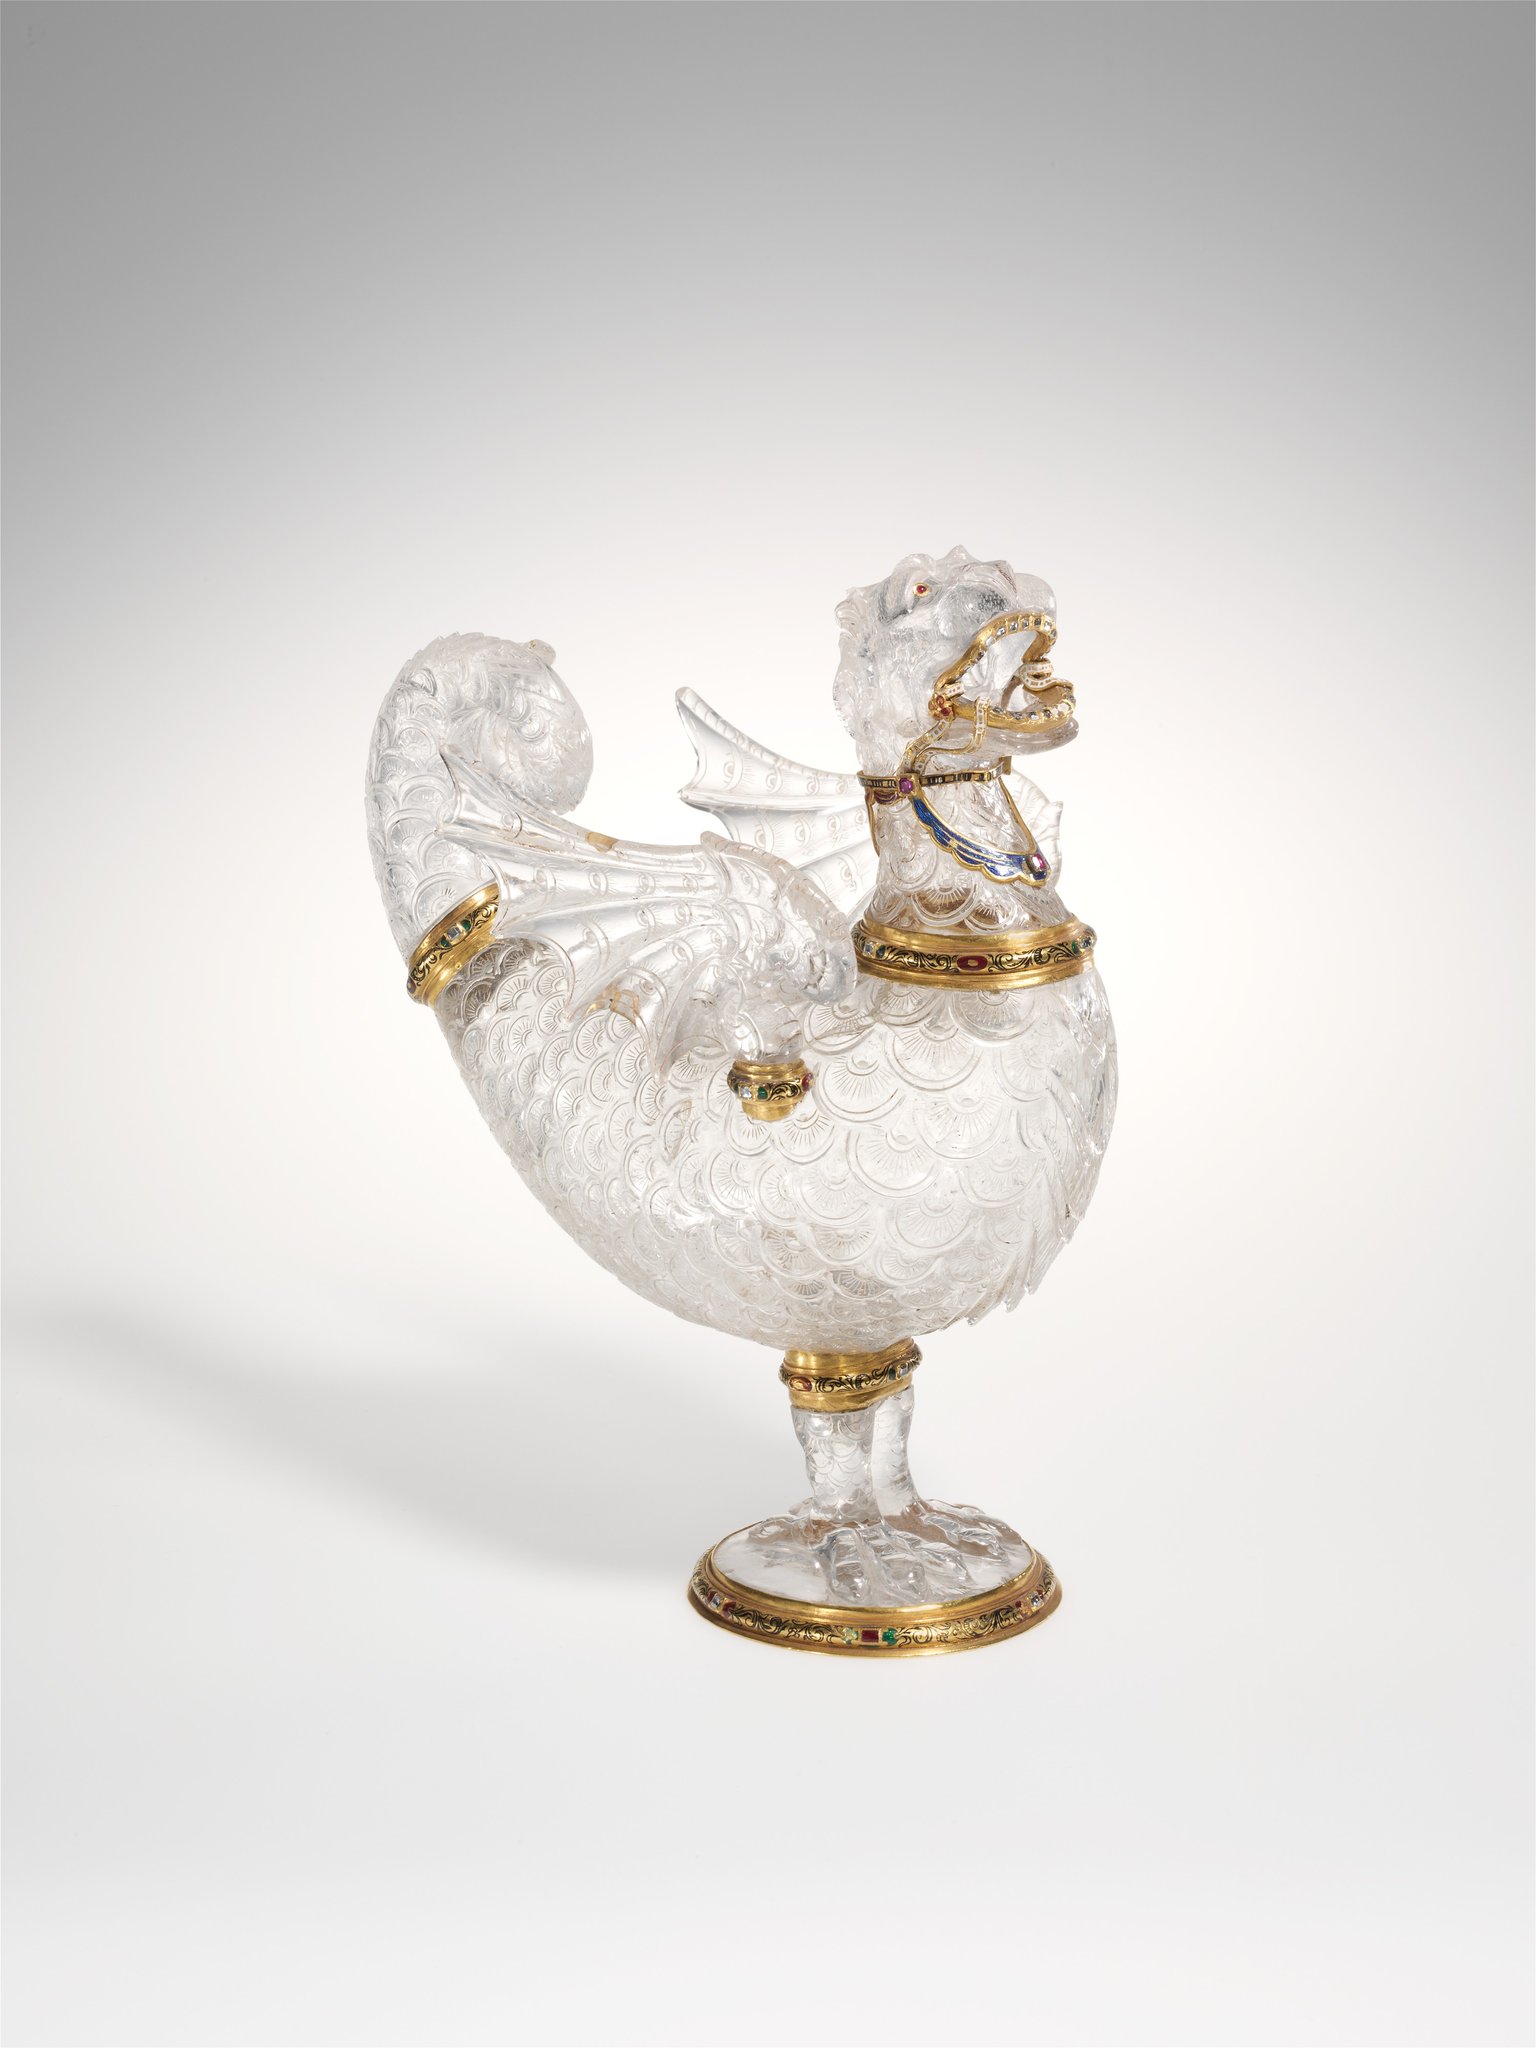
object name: table ornament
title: Table ornament in the form of a monster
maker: the saracchi, milan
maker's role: maker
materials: diamond, gold, quartz, gemstone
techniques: enamel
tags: monsters